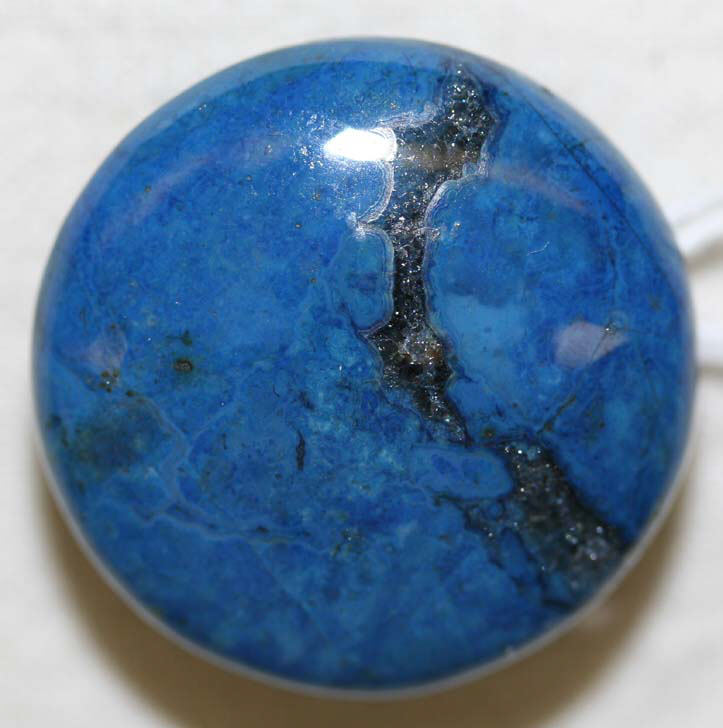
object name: cuff link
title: Cuff links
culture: american or european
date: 1834-1866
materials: lapis lazuli